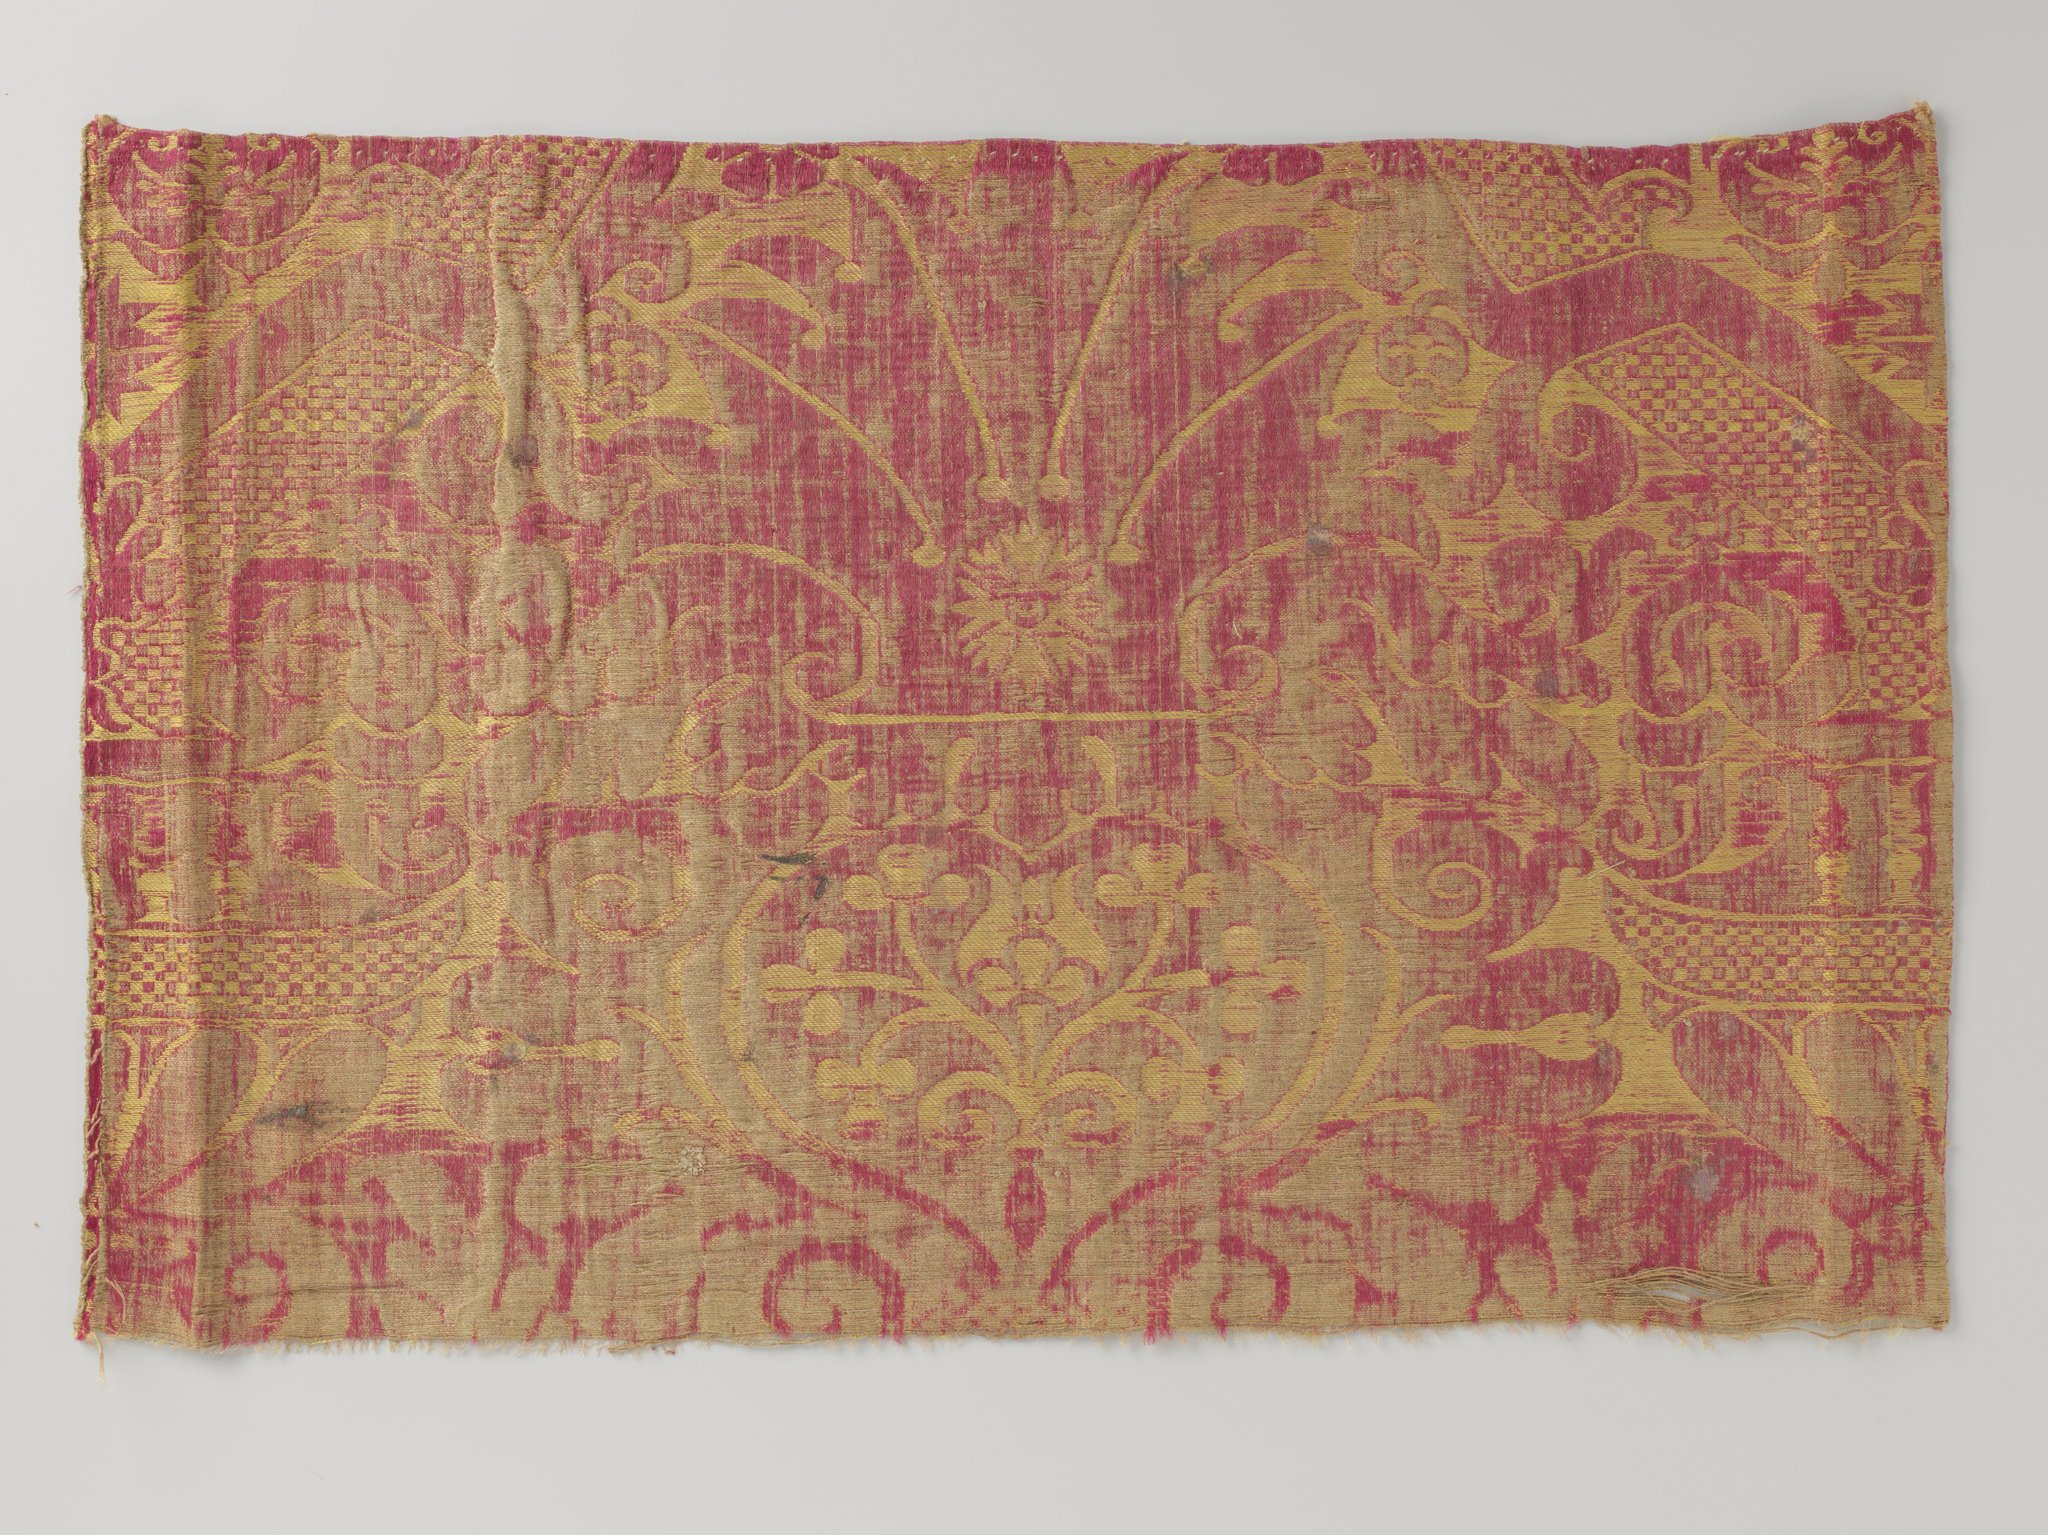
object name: fragment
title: Fragment geel met rode zijdebrocatel met patroon van bloemornament geflankeerd door vazen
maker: Anonymous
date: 1500-1599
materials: textile, linen, silk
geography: spain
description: Fragment geel met rode zijdebrocatel met patroon van een groot bloemornament, geflankeerd door vazen waaruit zich brede slingers ontwikkelen. Fond wordt gevormd door de gele schering.